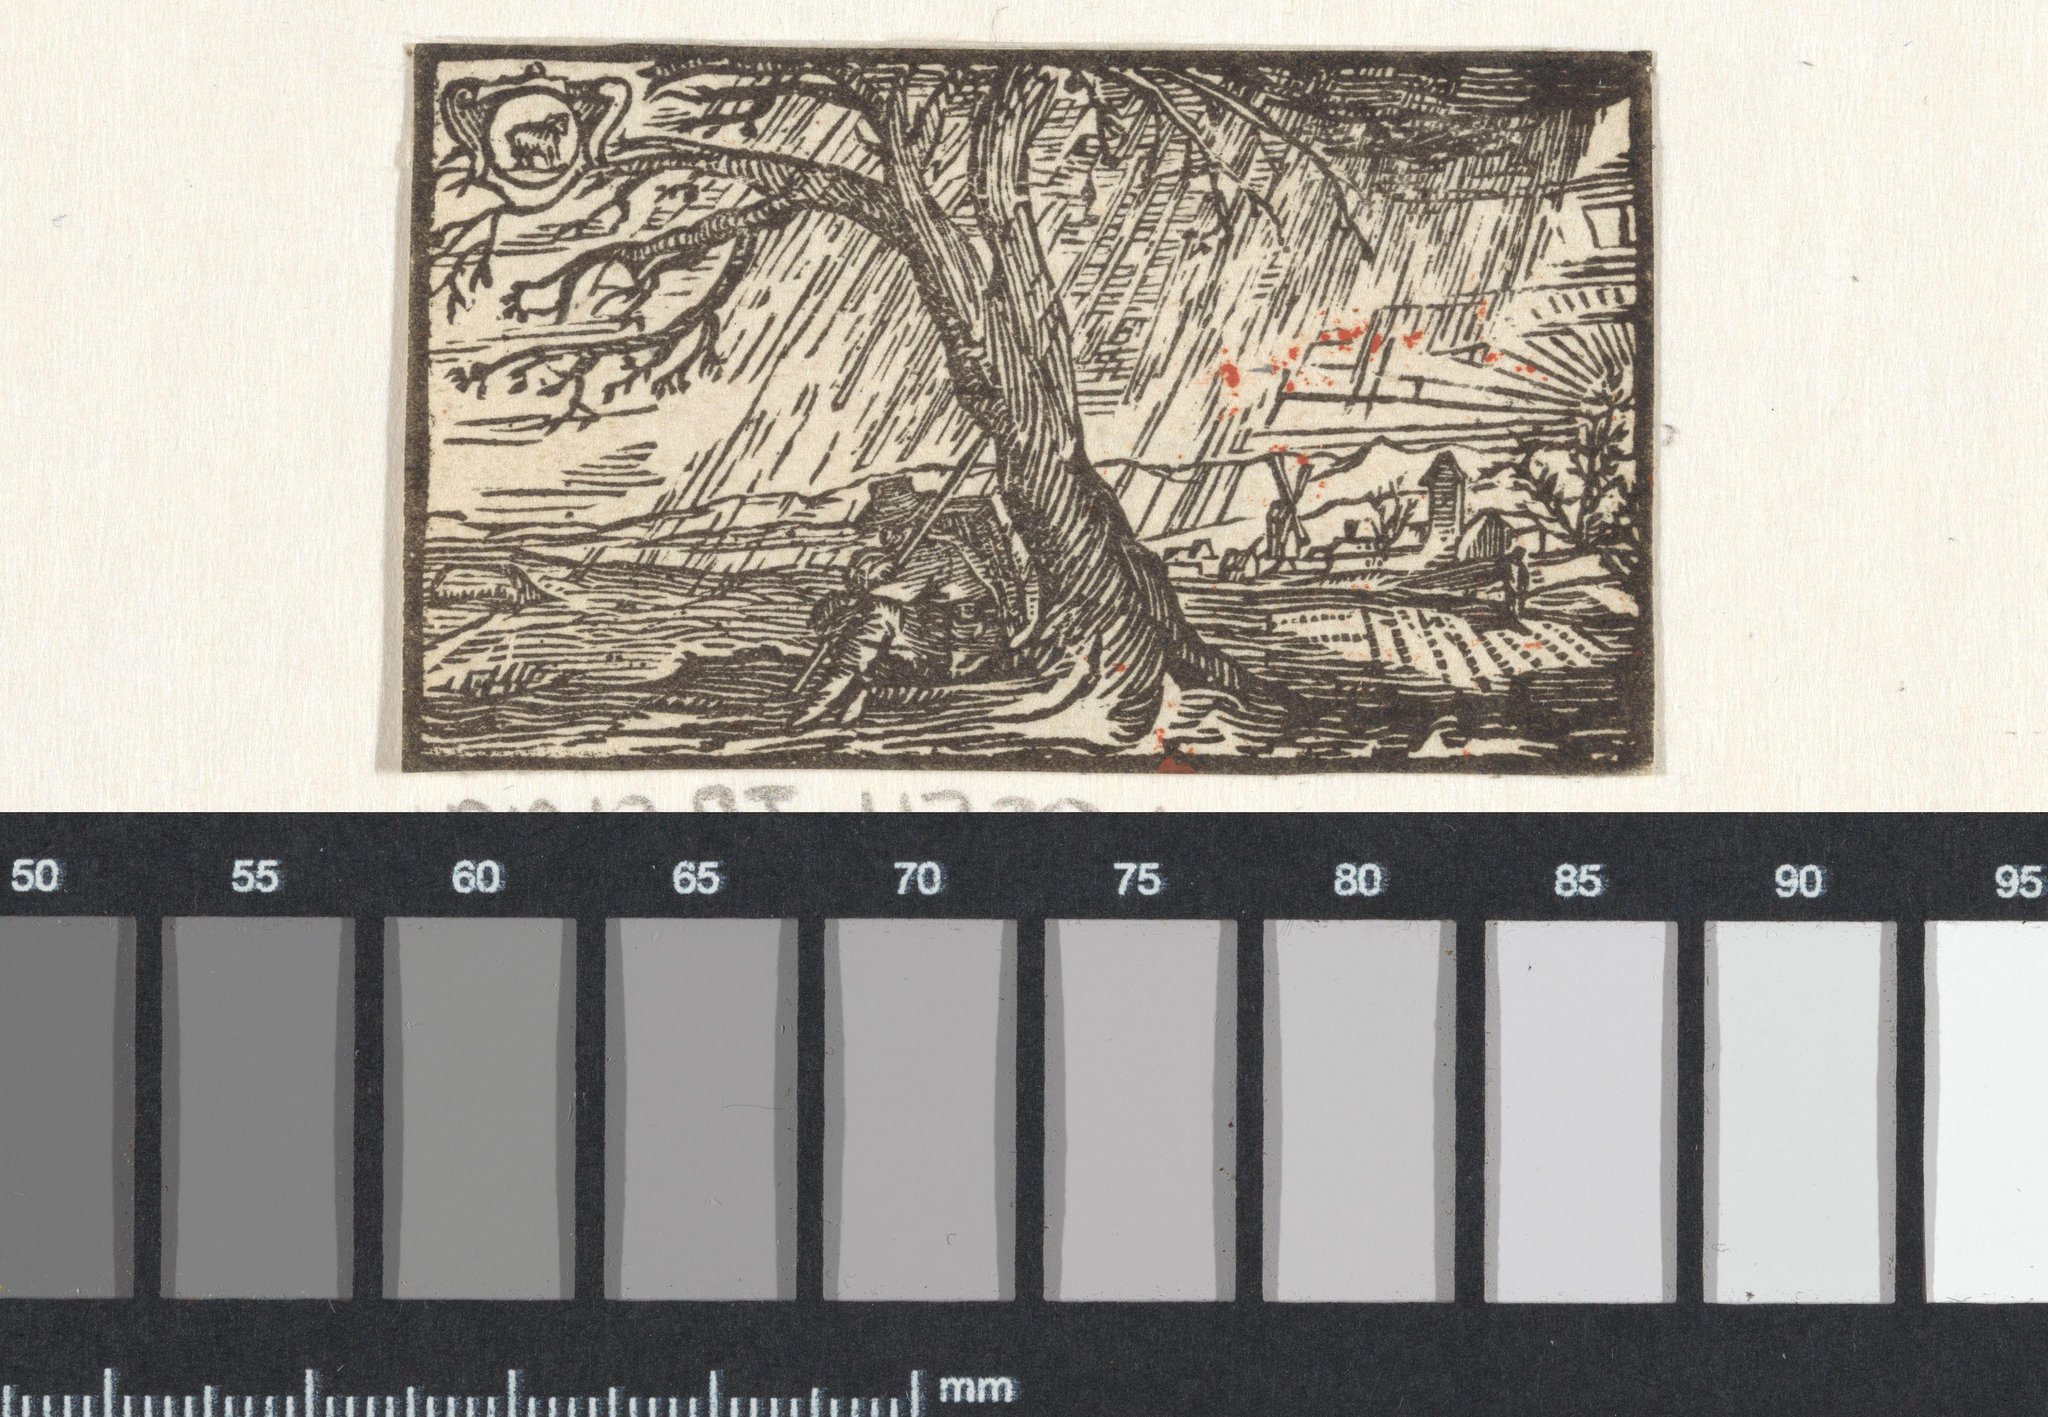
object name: print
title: Maart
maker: Anonymous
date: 1600-1699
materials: paper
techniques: woodcut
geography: netherlands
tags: march and its 'labours' (+ with aries (march)), rain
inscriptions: collector's mark: Lugt 2228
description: Een man zittend onder een boom in een regenbui. Linksboven een ram.